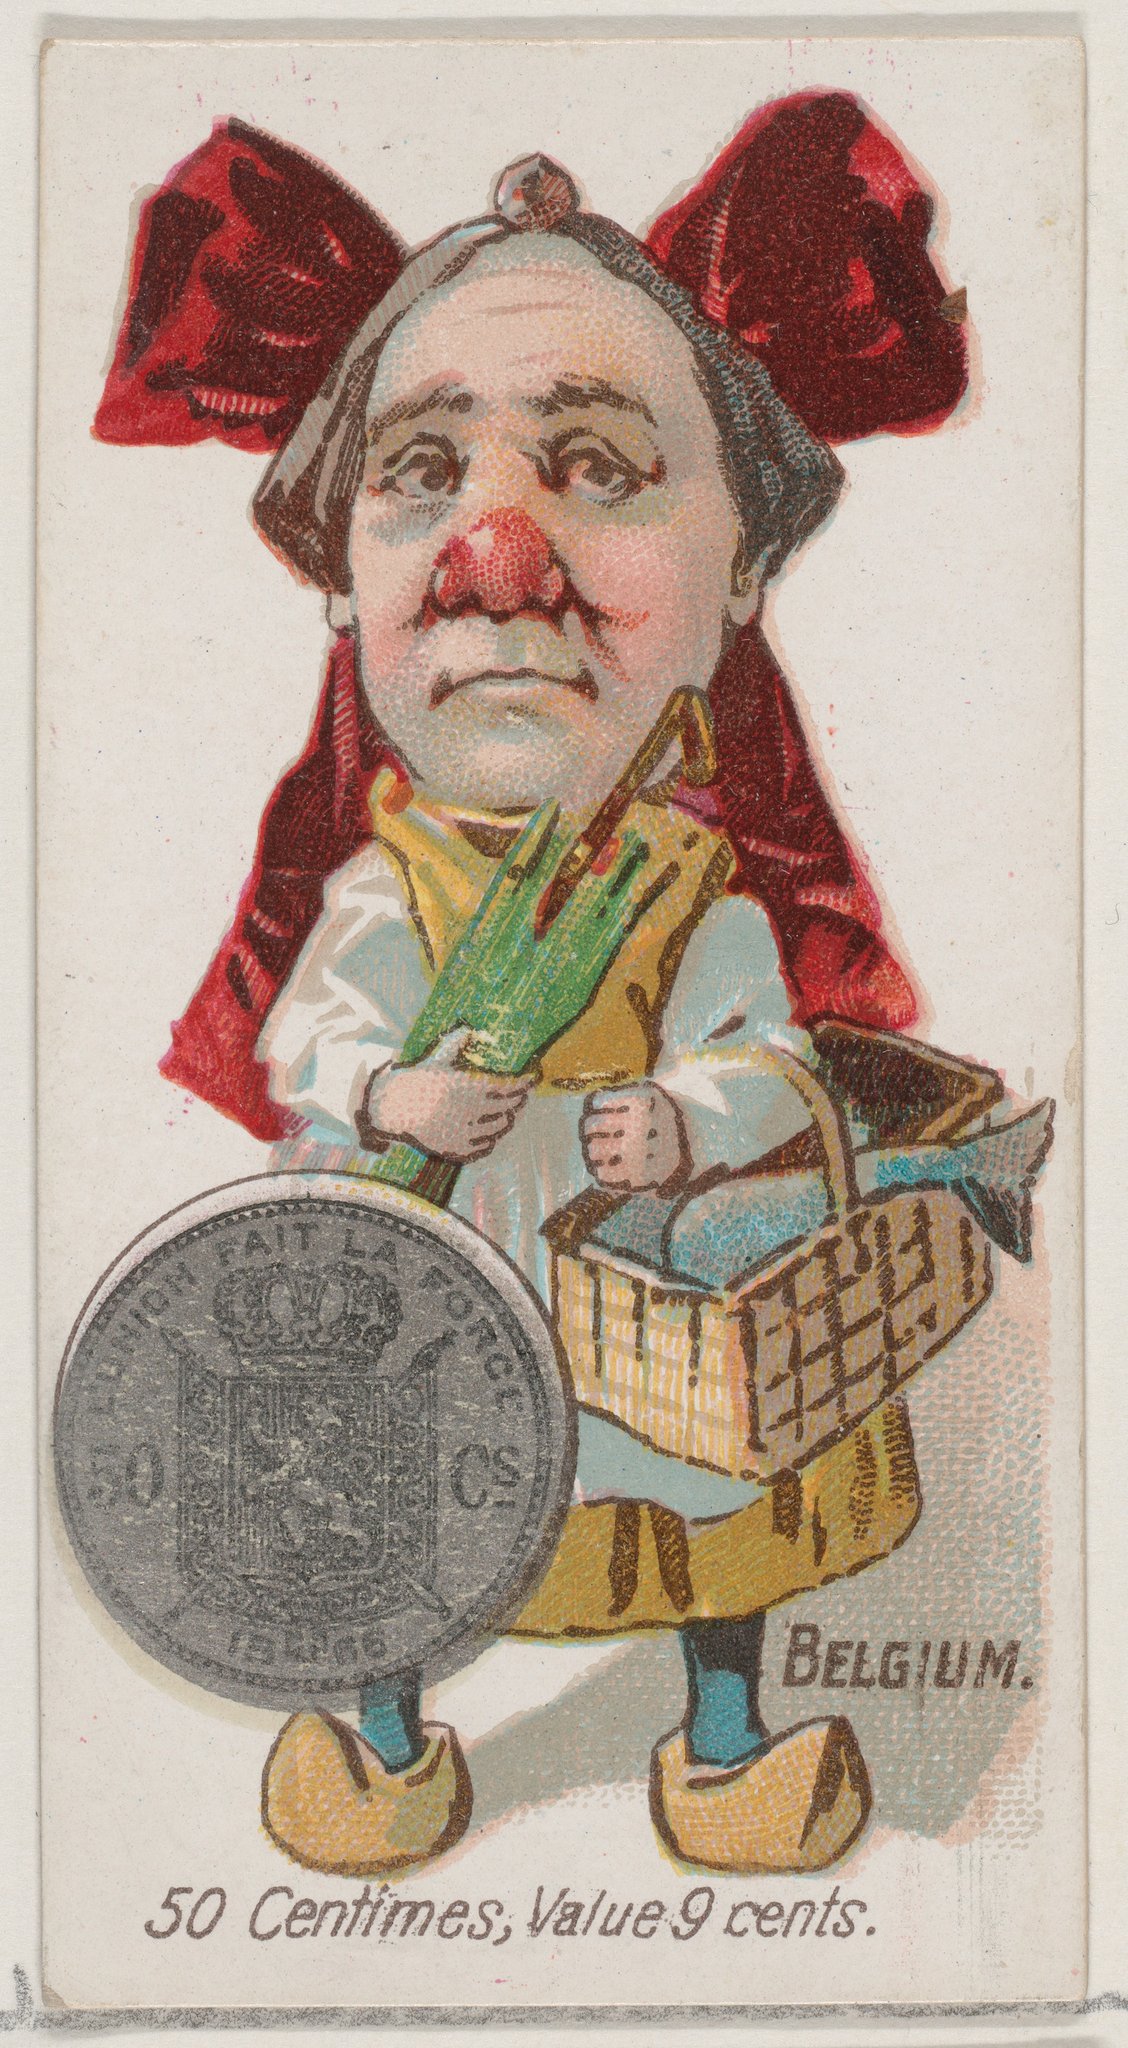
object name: print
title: Caricatured Belgian, 50 Centimes, from the series Coins of All Nations (N72, variation 1) for Duke brand cigarettes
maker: w. duke, sons & co.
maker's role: publisher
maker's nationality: american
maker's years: 1870-1920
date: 1889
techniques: color lithograph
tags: coins